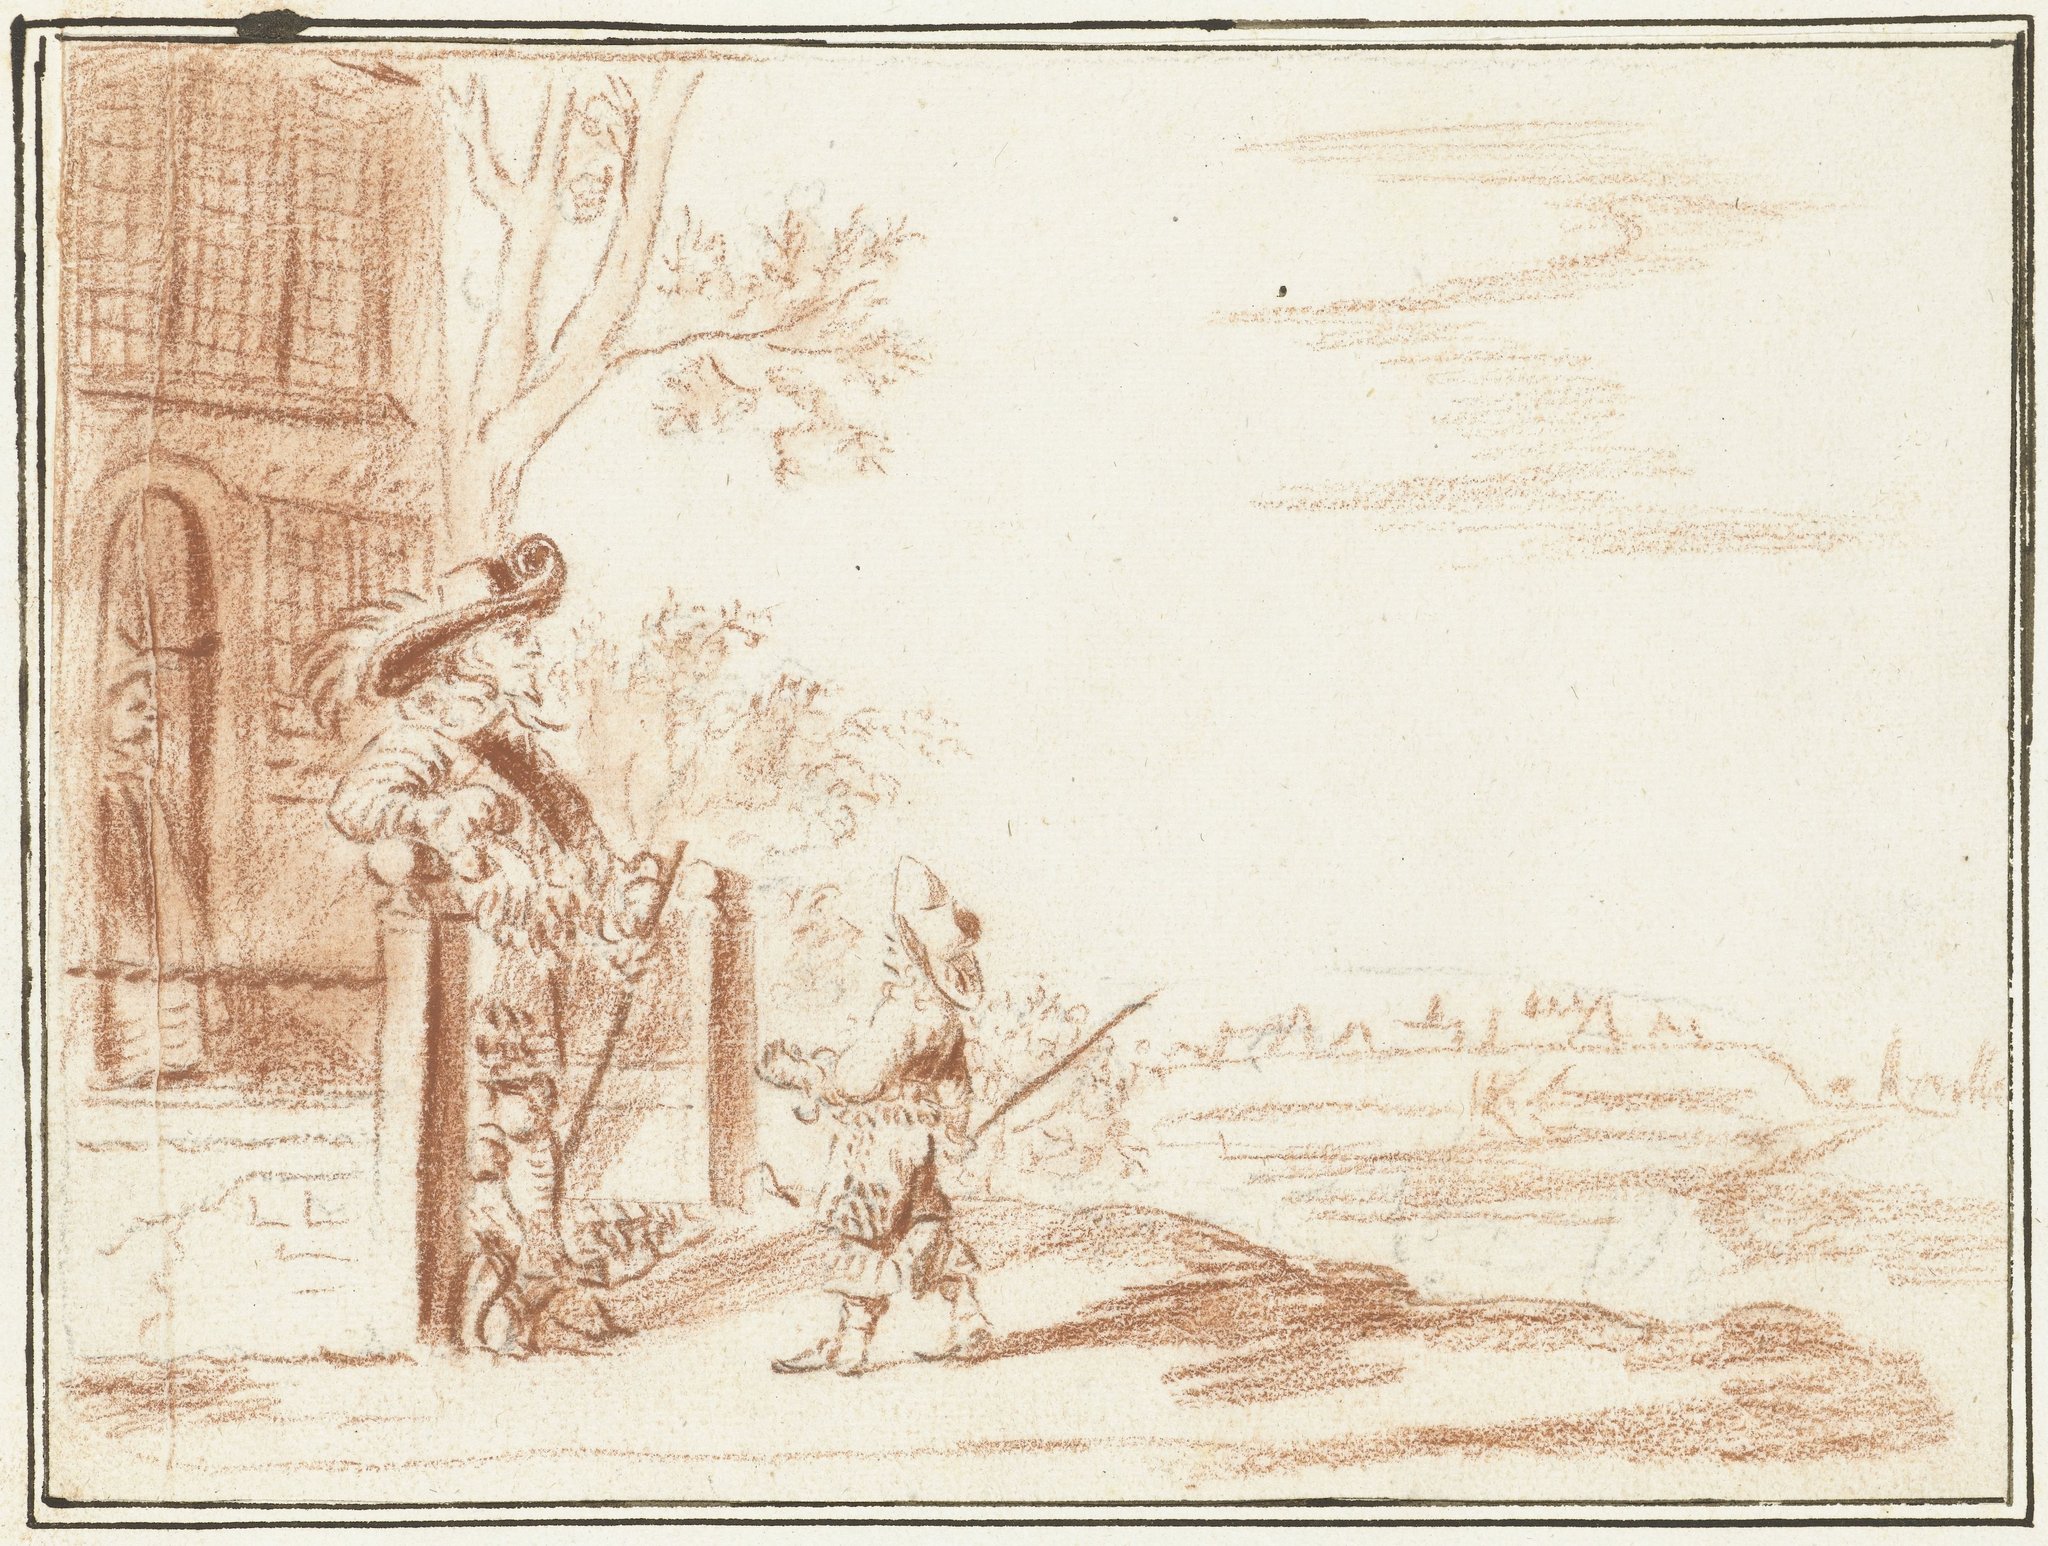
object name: drawing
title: Twee heren en een jongen (page?) bij een landhuis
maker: gesina ter borch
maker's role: draughtsman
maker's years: 1633-1690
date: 1656-1687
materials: chalk, paper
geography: zwolle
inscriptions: watermark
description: Tekening naast twee andere tekeningen in het Familie-plakboek geplakt.